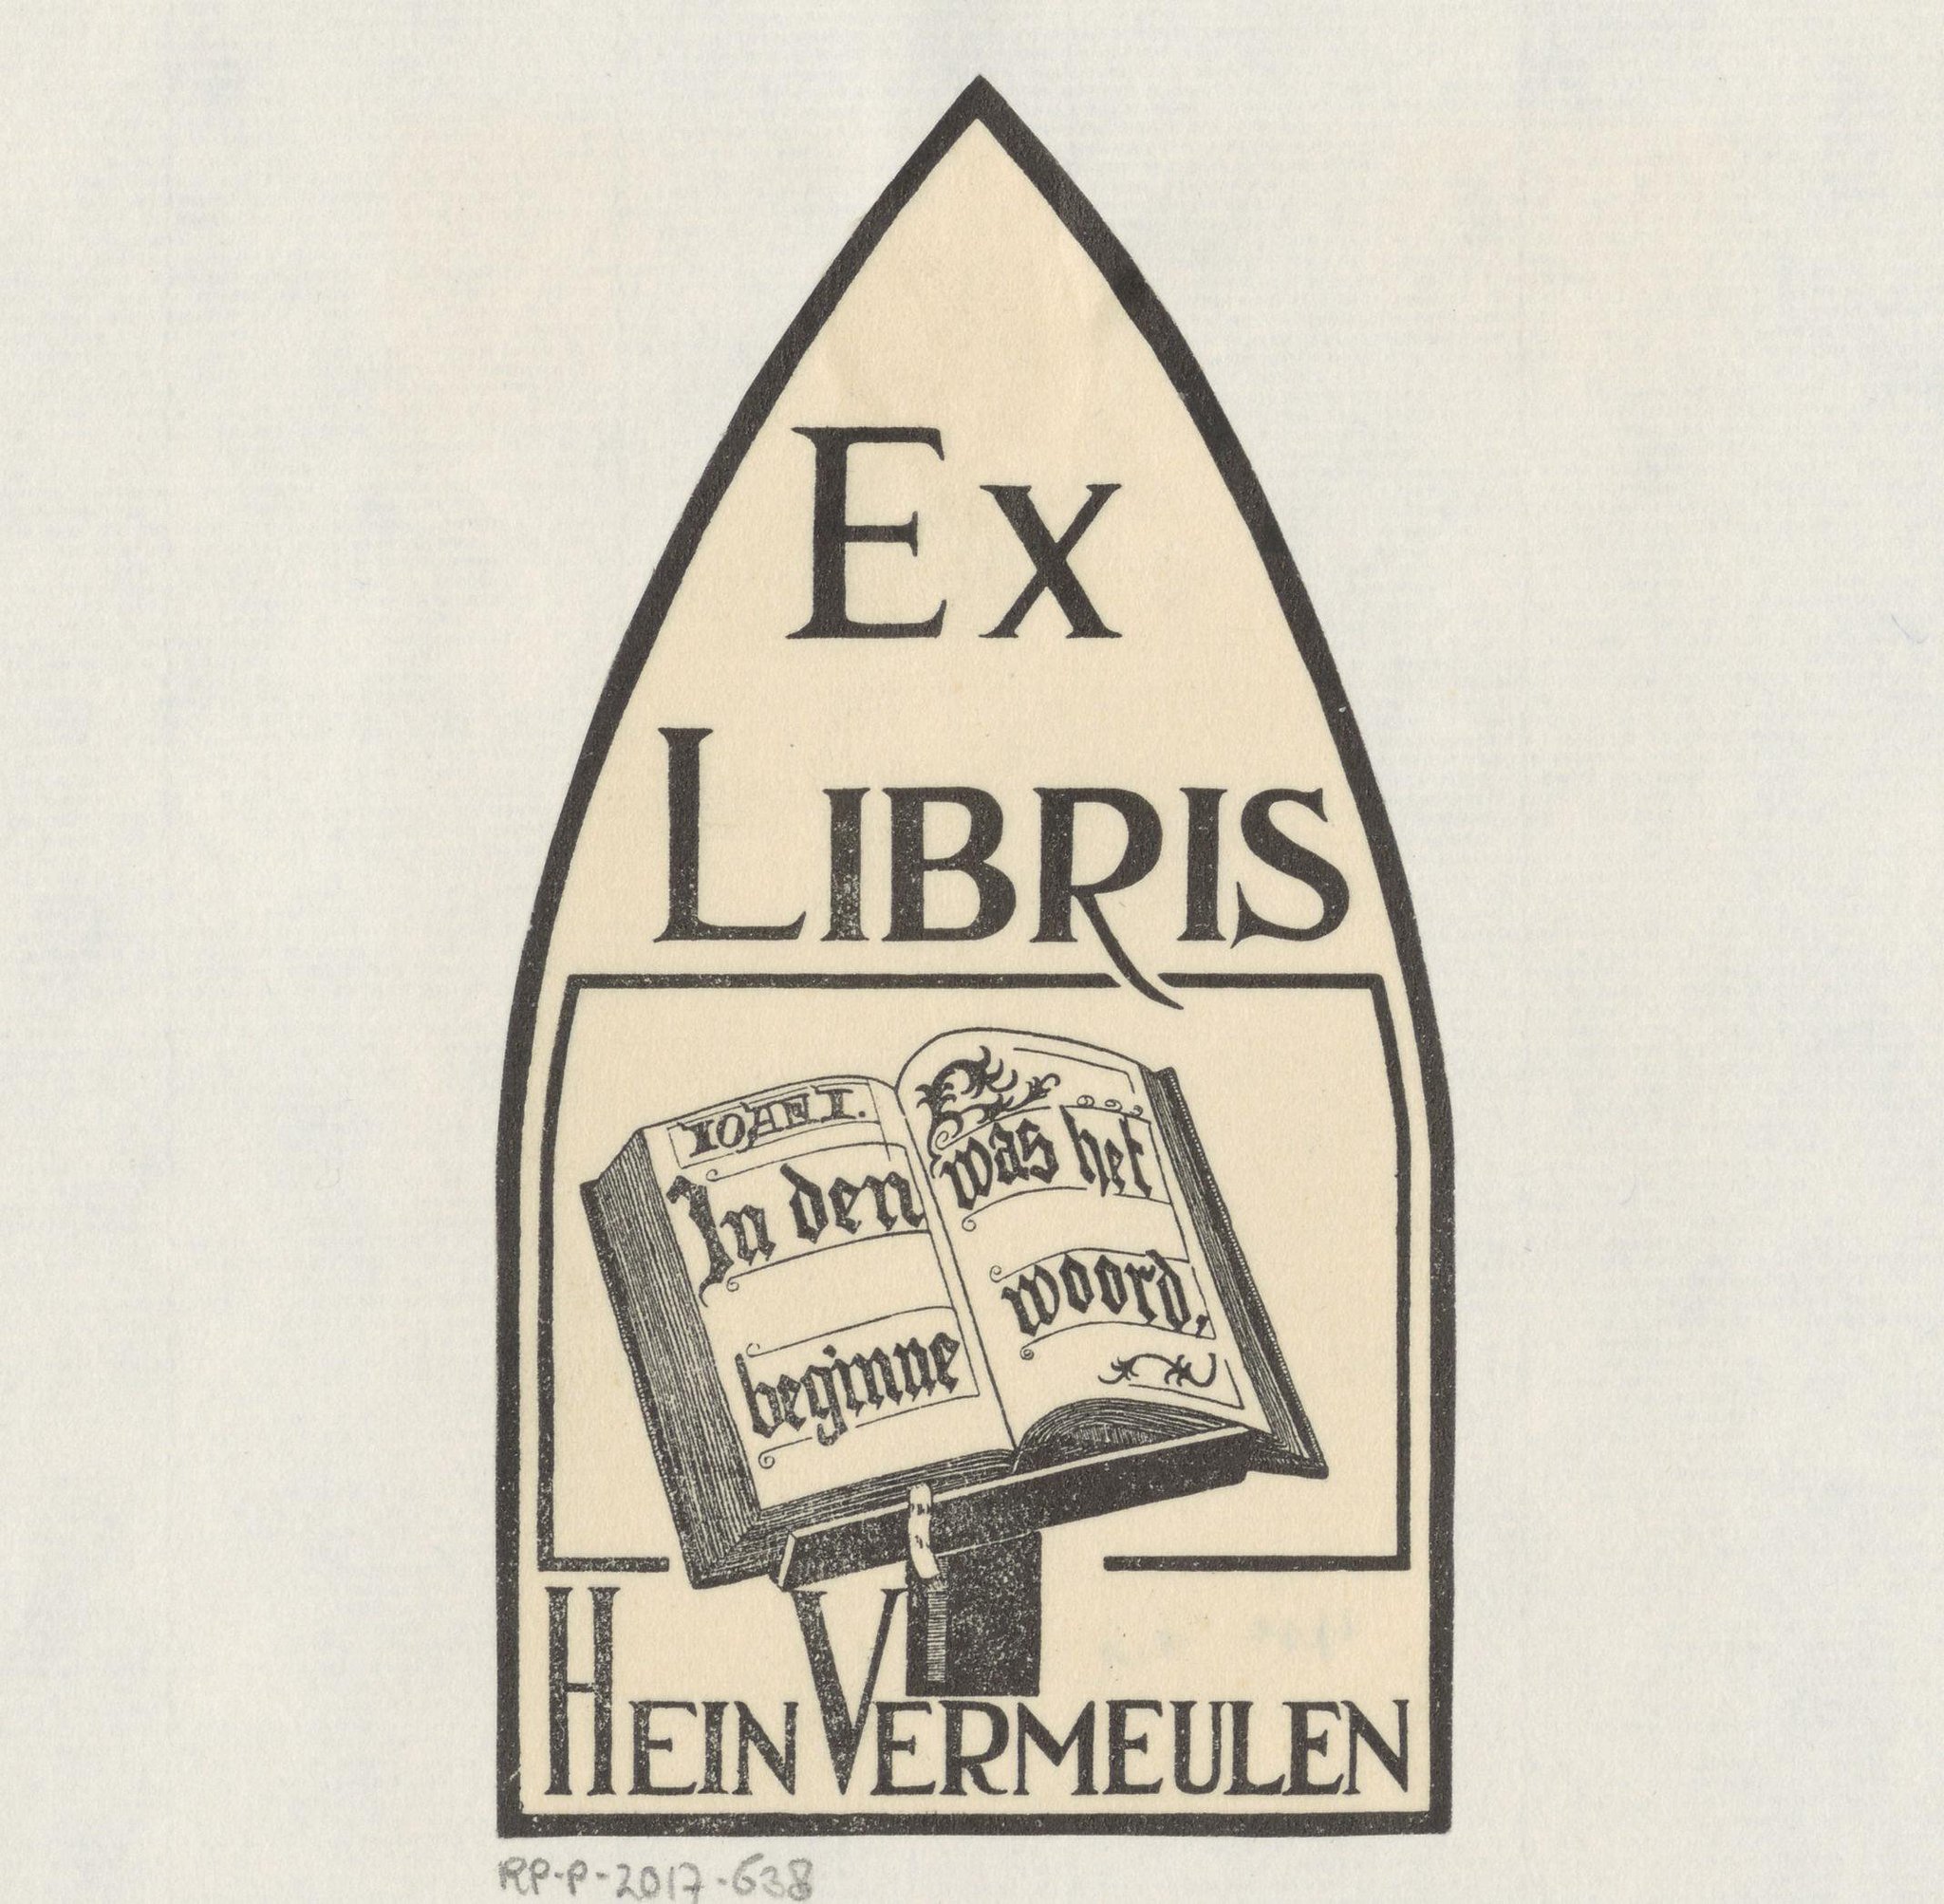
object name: bookplate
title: Ex libris van Hein Vermeulen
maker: hein vermeulen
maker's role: print maker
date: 1900-1999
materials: paper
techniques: printing block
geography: netherlands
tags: hein vermeulen, bible, book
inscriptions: inscription: ‘ipse’